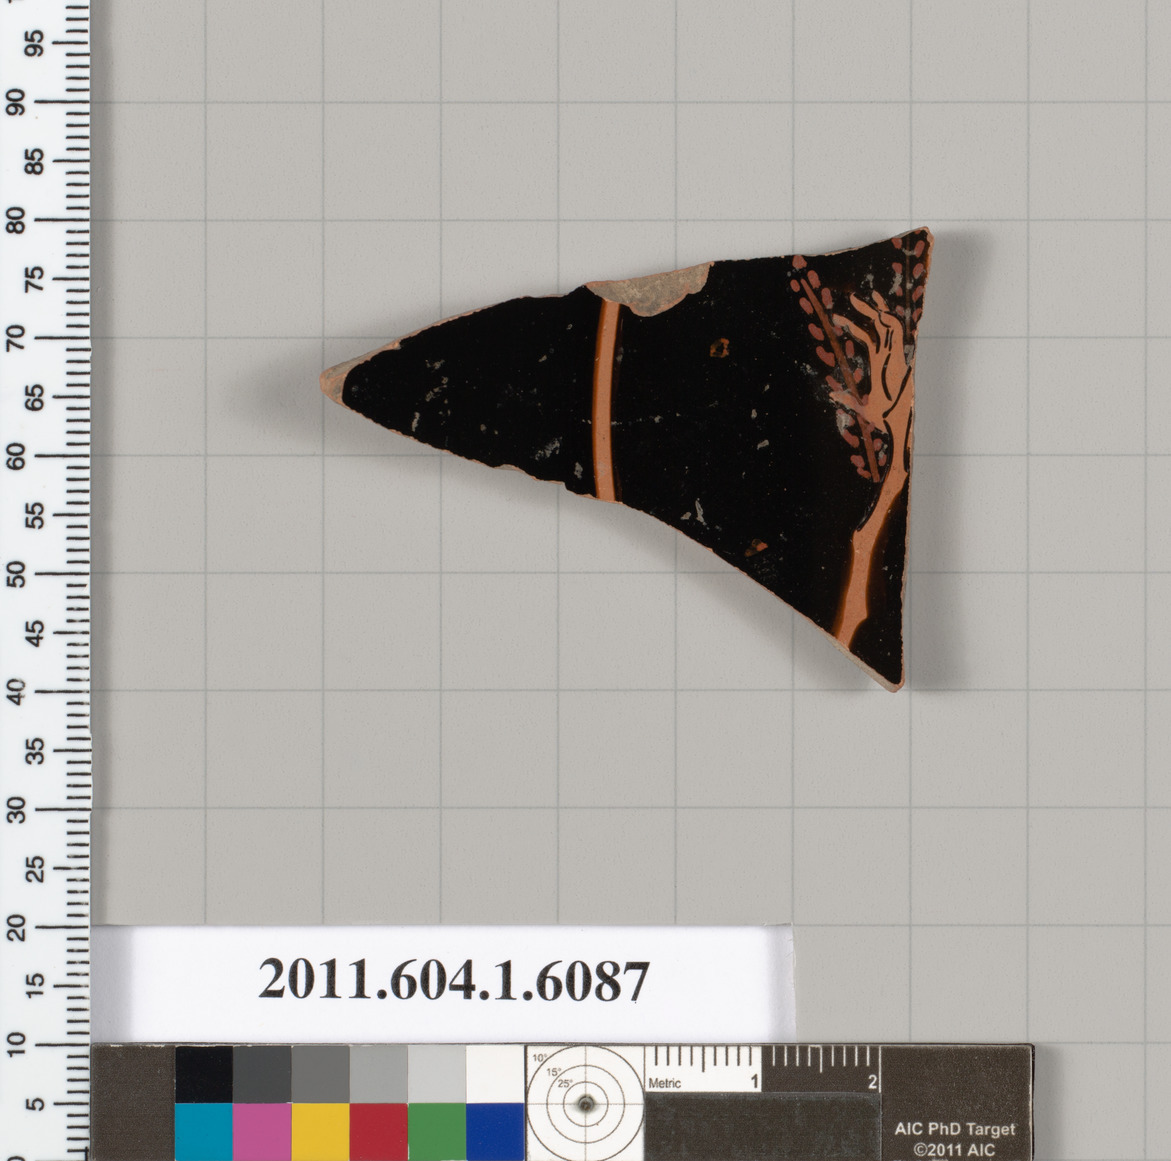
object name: kylix fragment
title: Terracotta fragment of a kylix (drinking cup)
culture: greek, attic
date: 500-490 BCE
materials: terracotta